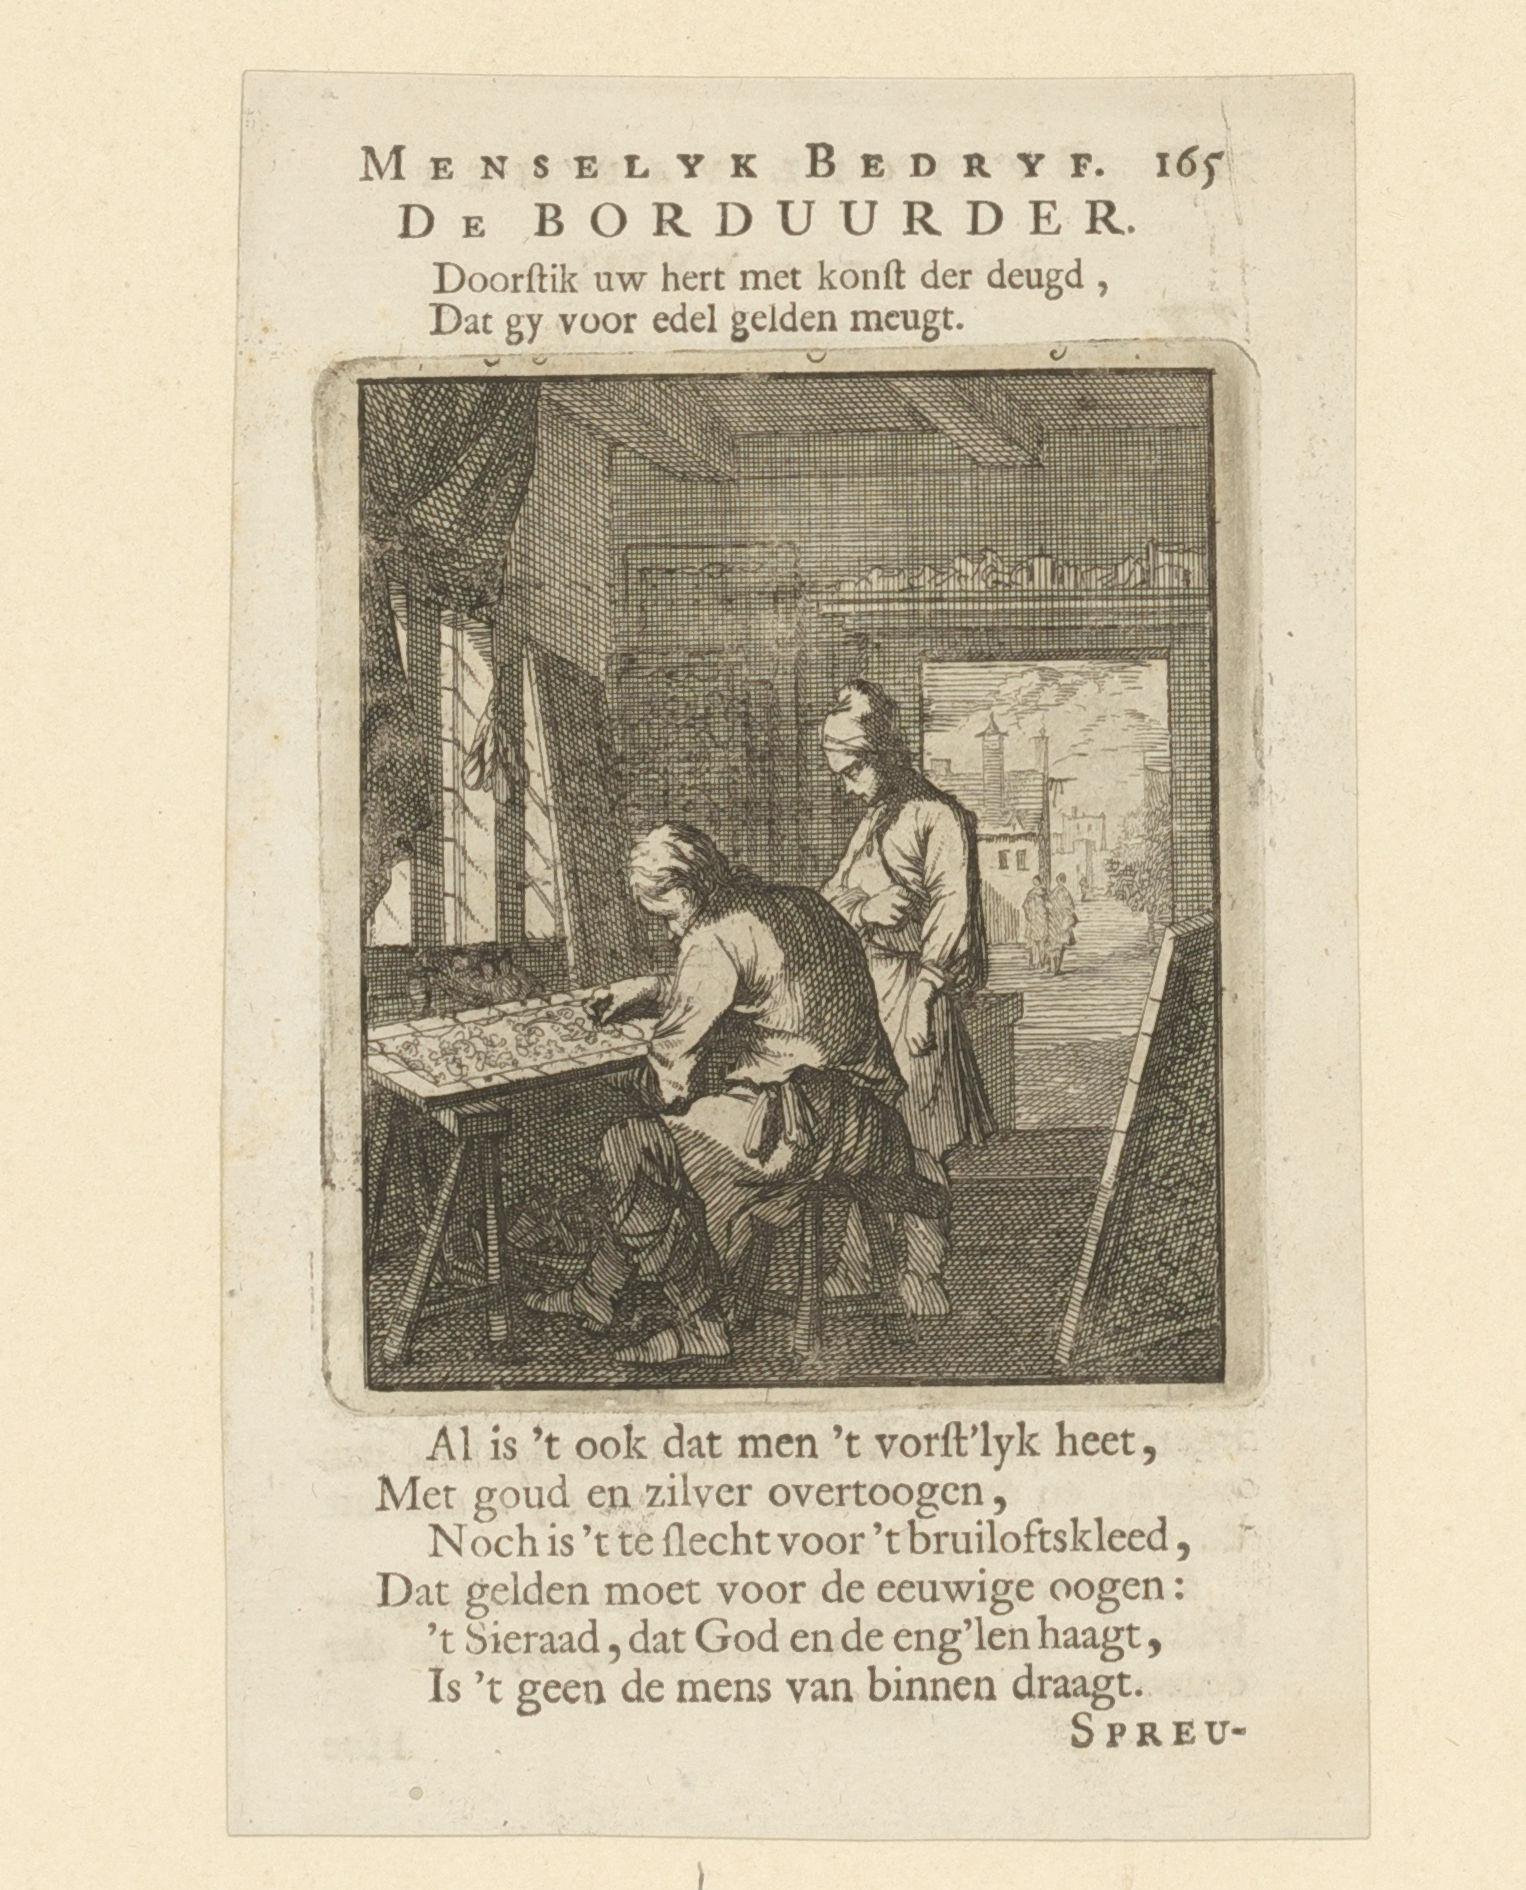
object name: print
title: Borduurder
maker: cornelis van der sys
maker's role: publisher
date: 1718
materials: paper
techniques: etching, letterpress printing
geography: amsterdam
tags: embroidering ~ textile industry, handicrafts, craftsman at work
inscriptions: collector's mark: Lugt 1641, stamp, stamp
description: Prent oorspronkelijk verschenen in de 100-delige serie beroepsprenten van Jan en Caspar Luyken, getiteld: Het menselyk bedryf. S.l.s.n., 1694 (eerste druk). Daarna is de titel en het vers afgesneden. De prenten in diverse publicaties verschenen en gekopieerd. Huidige staat uit: Luyken, Jan en Caspar. Spiegel van het menselyk bedryf (...). Amsterdam: Cornelis van der Sys, 1718, p. 165. Prent waarschijnlijk ook gebruikt in eerdere (1704) en latere (1730, 1749, 1767) publicaties.